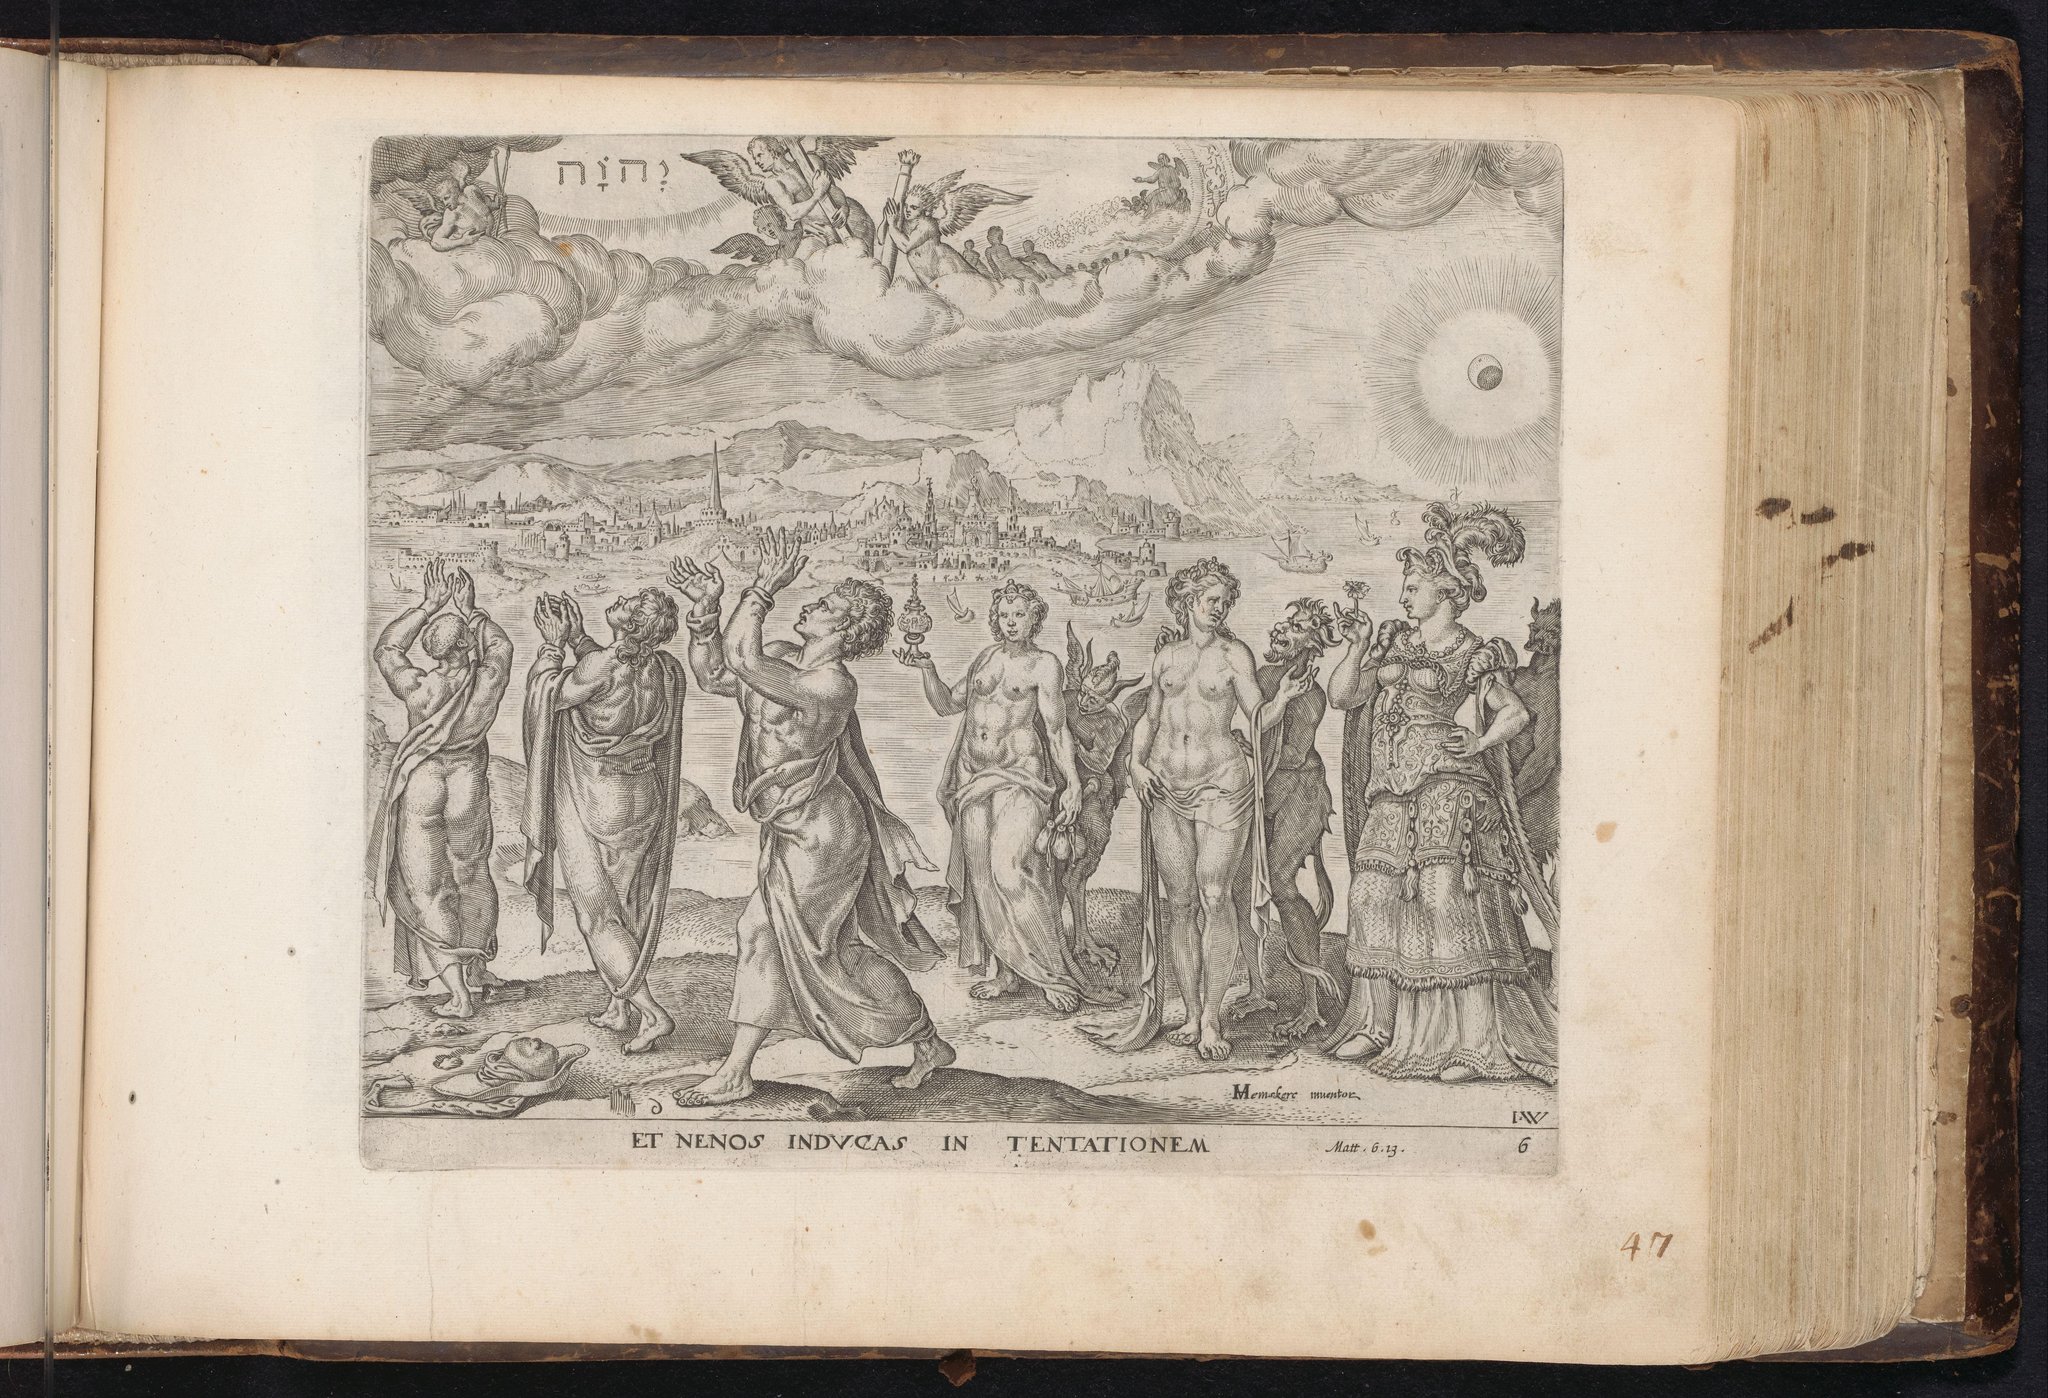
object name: album leaf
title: Van het Vader Onse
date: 1569-1573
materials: paper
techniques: engraving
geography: alkmaar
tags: tetragram (in roman or hebrew script) ~ symbol of god the father, 'and lead us not into temptation' ~ the lord's prayer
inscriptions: number: ‘47’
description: Illustratie van een regel van het Onze Vader gebed: Breng ons niet in beproeving. Mannen bidden tot de hemel, waar het tetragram als symbool van God de Vader verschijnt. Rechts staan drie personificaties van beproevingen: Geld, Lust en Eerzucht. Achter hen gaan duivels schuil. Onder de voorstelling dit gedeelte van het Onze Vader in het Latijn en een verwijzing naar de Bijbeltekst in Mat. 6:13. Deze prent maakt deel uit van een album.